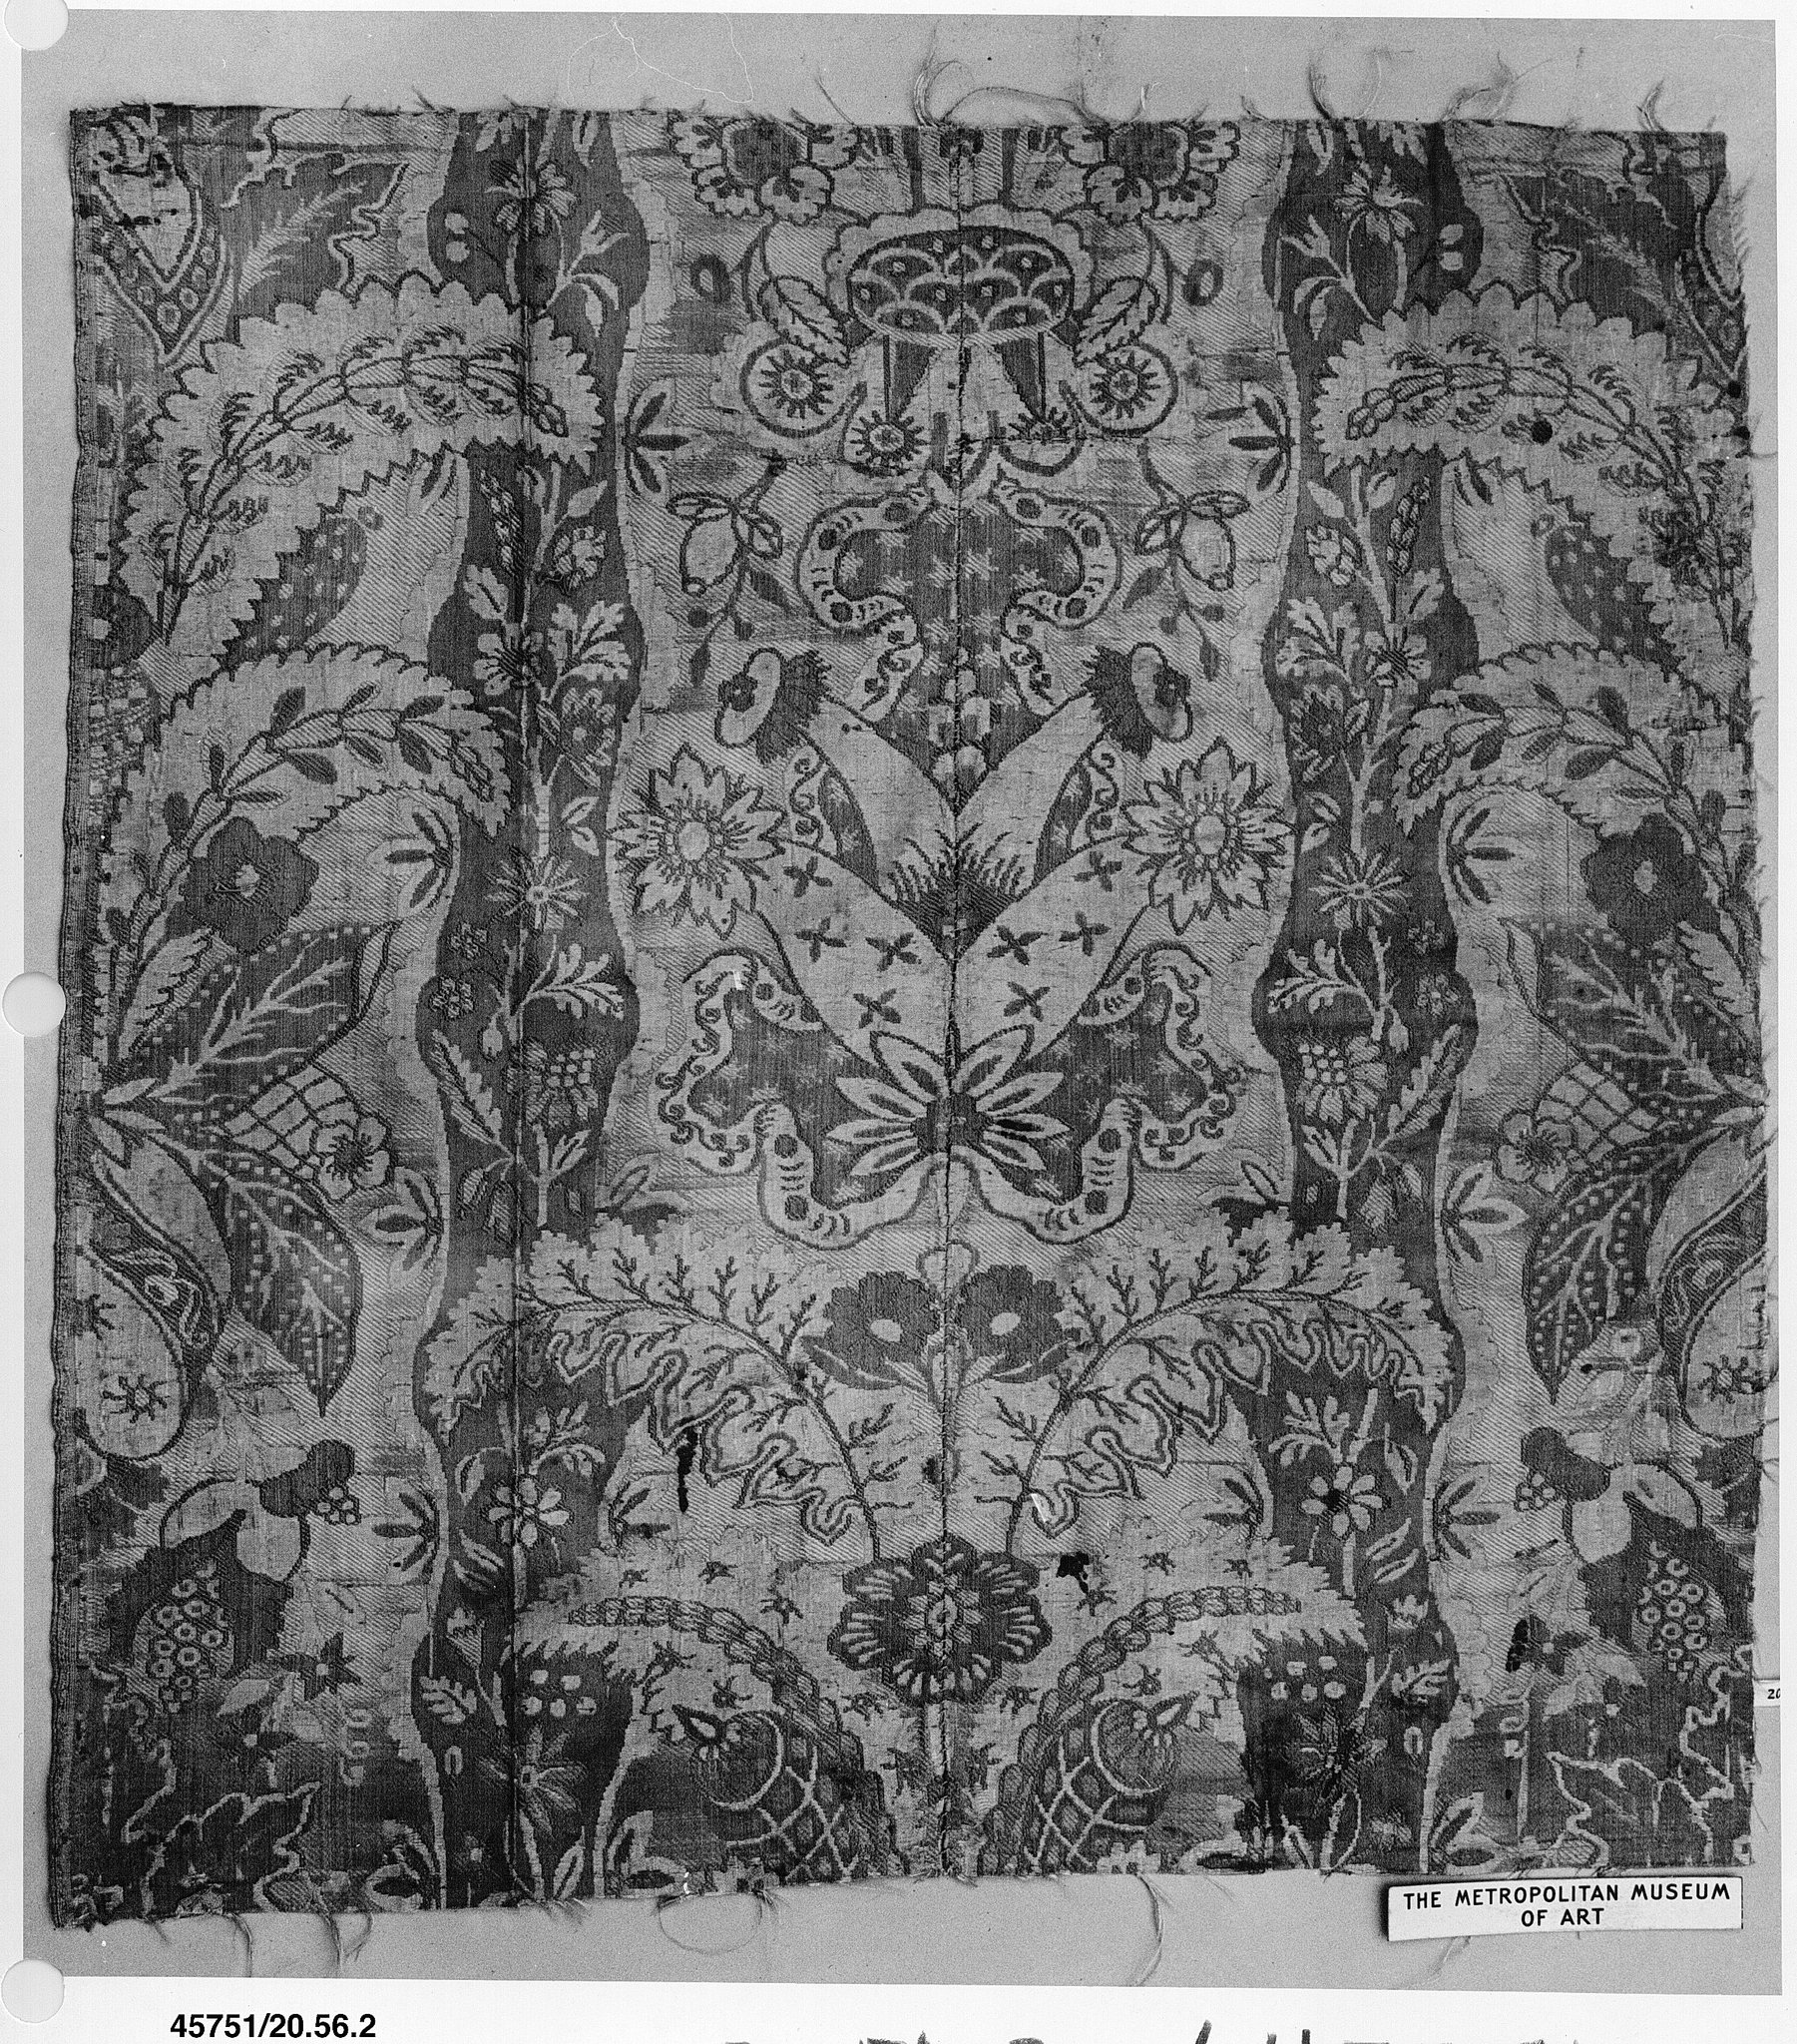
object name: piece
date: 1710-1720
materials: silk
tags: flowers,leaves